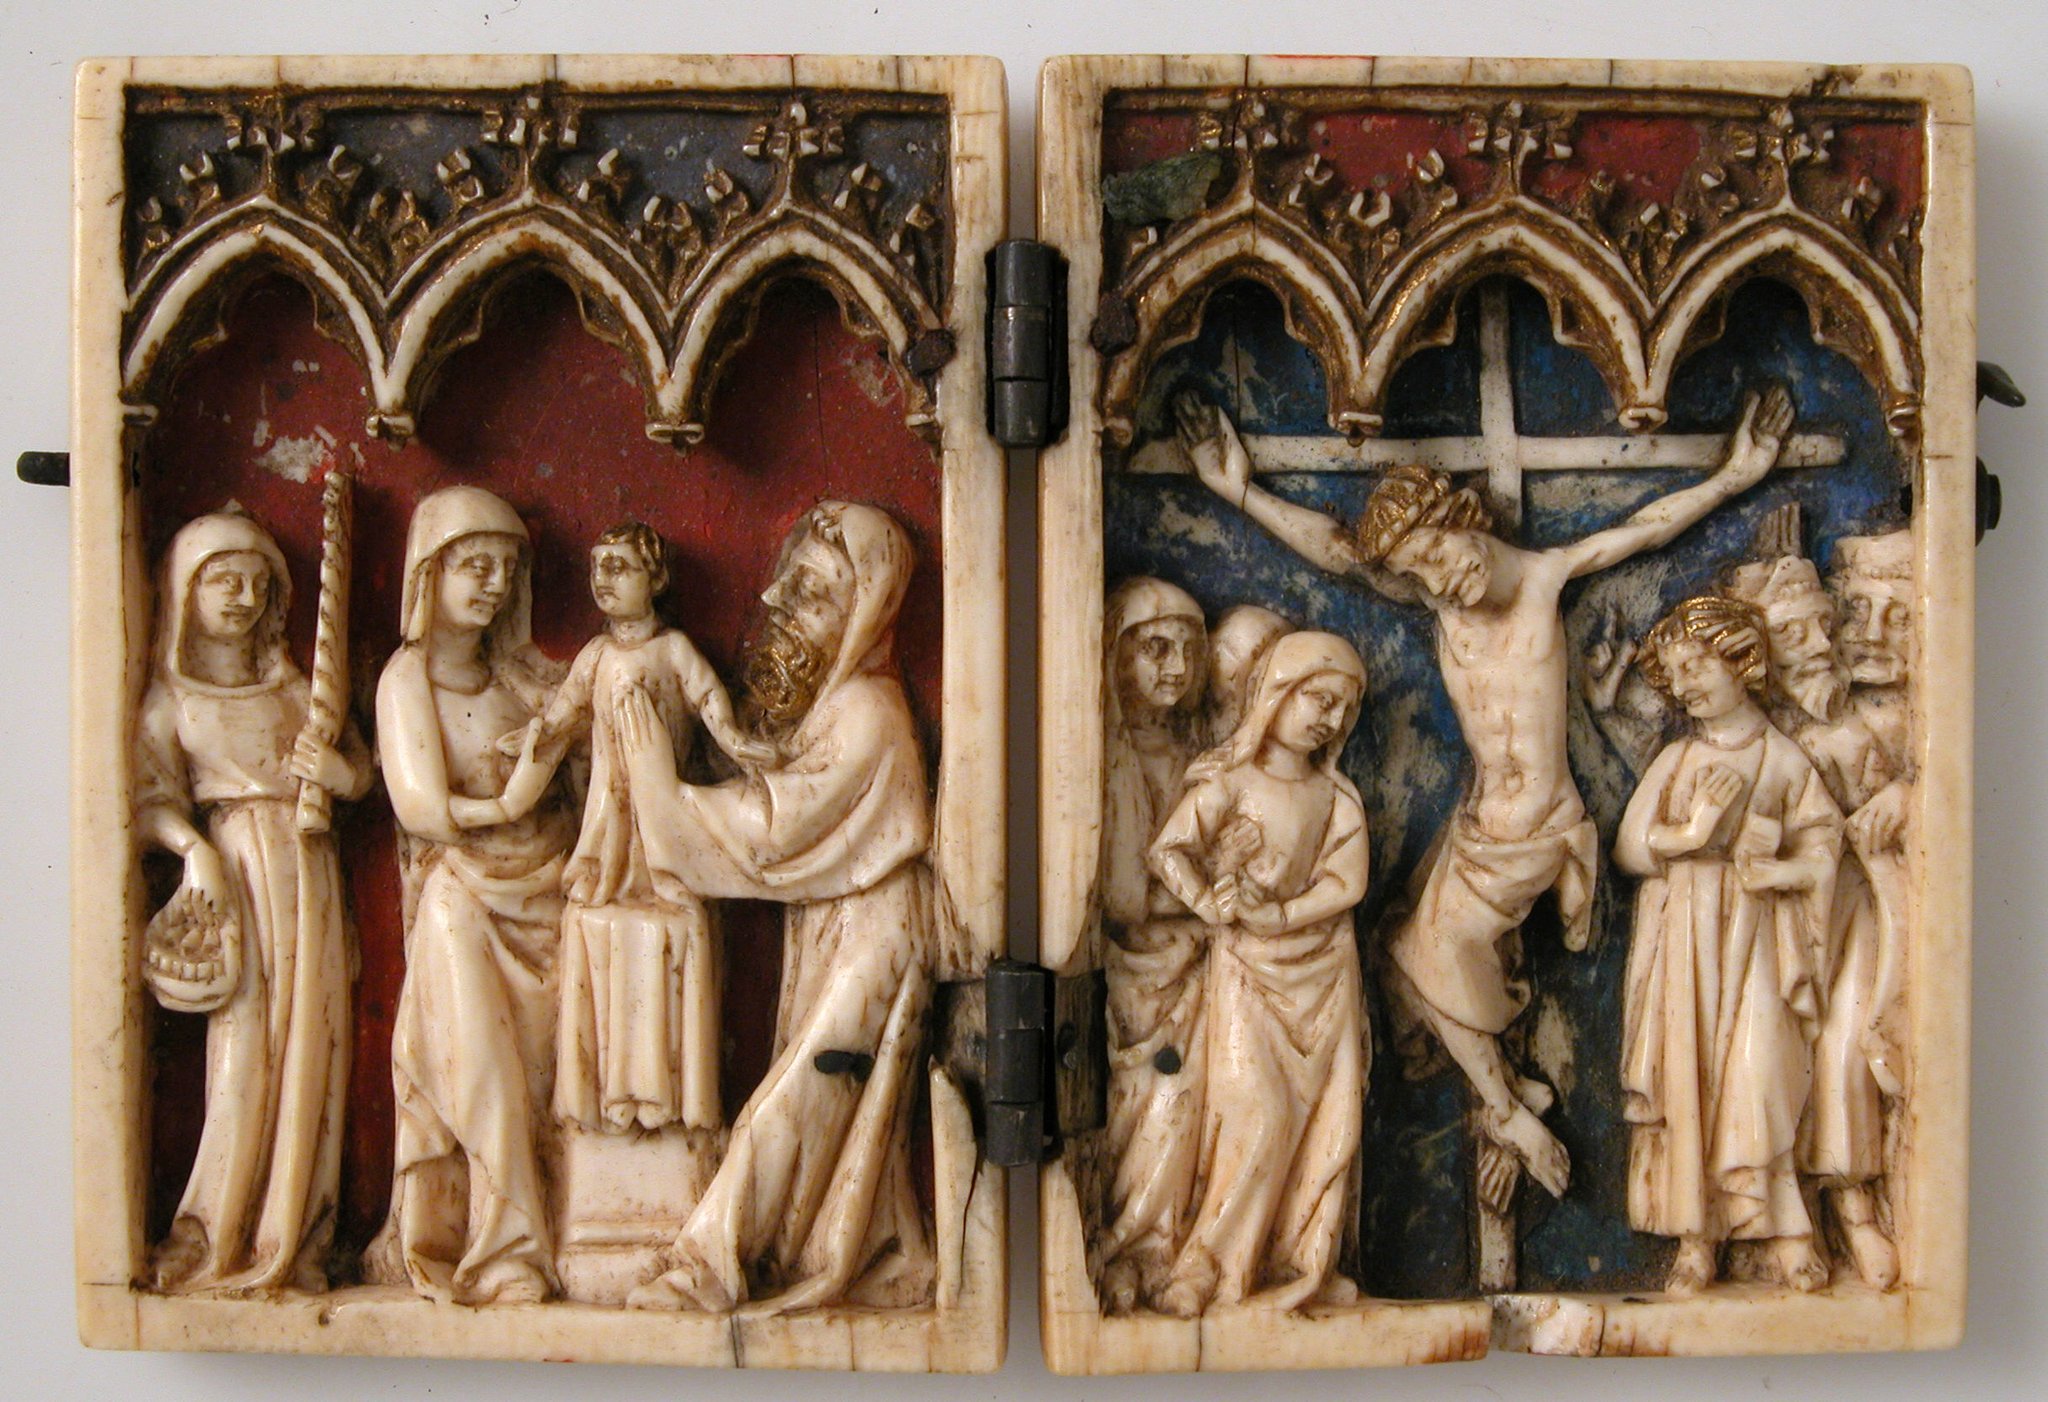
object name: diptych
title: Diptych with Presentation of Christ in the Temple and Crucifixion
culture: french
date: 1301-1400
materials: ivory, metal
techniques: polychromy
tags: christ,virgin mary